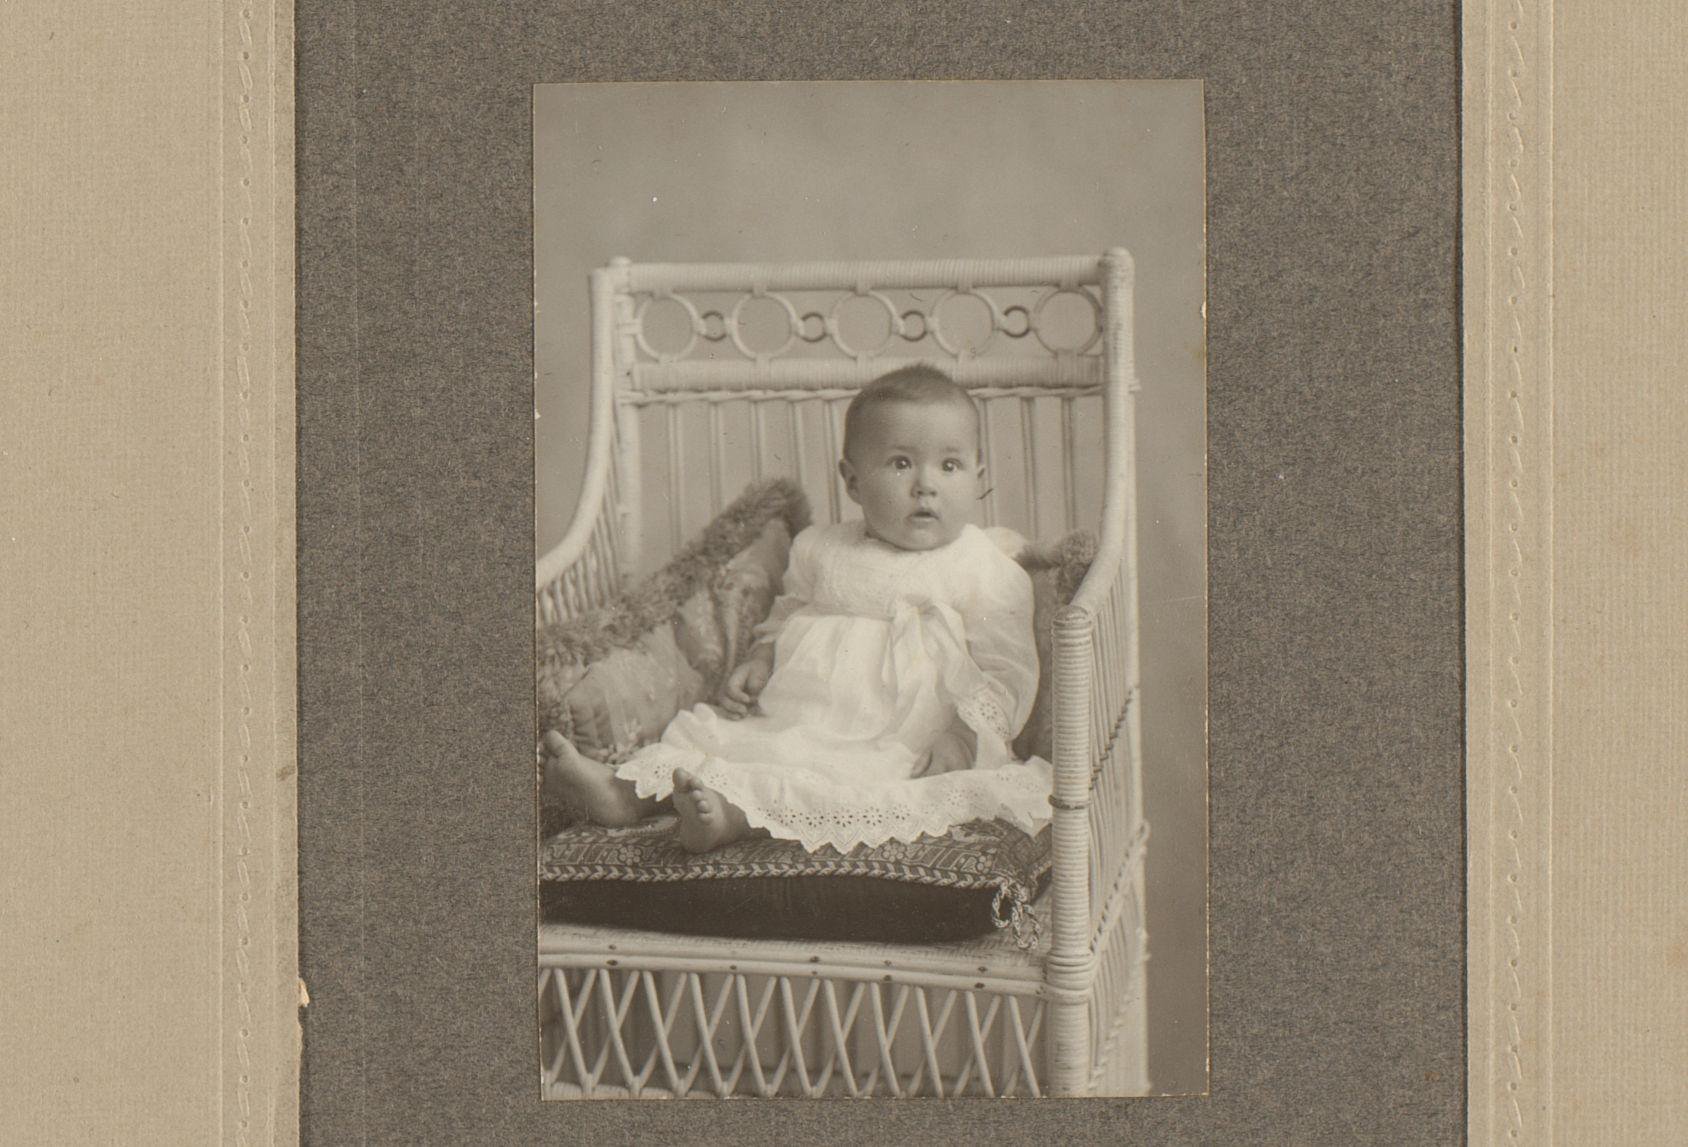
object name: photograph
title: Portret van Petronella Krui.., 9 maanden oud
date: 1907-1911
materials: paper, photographic support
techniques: gelatin silver print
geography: haarlem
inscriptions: title: ‘... na Petronella Krui... juli 1911 9 maanden oud’